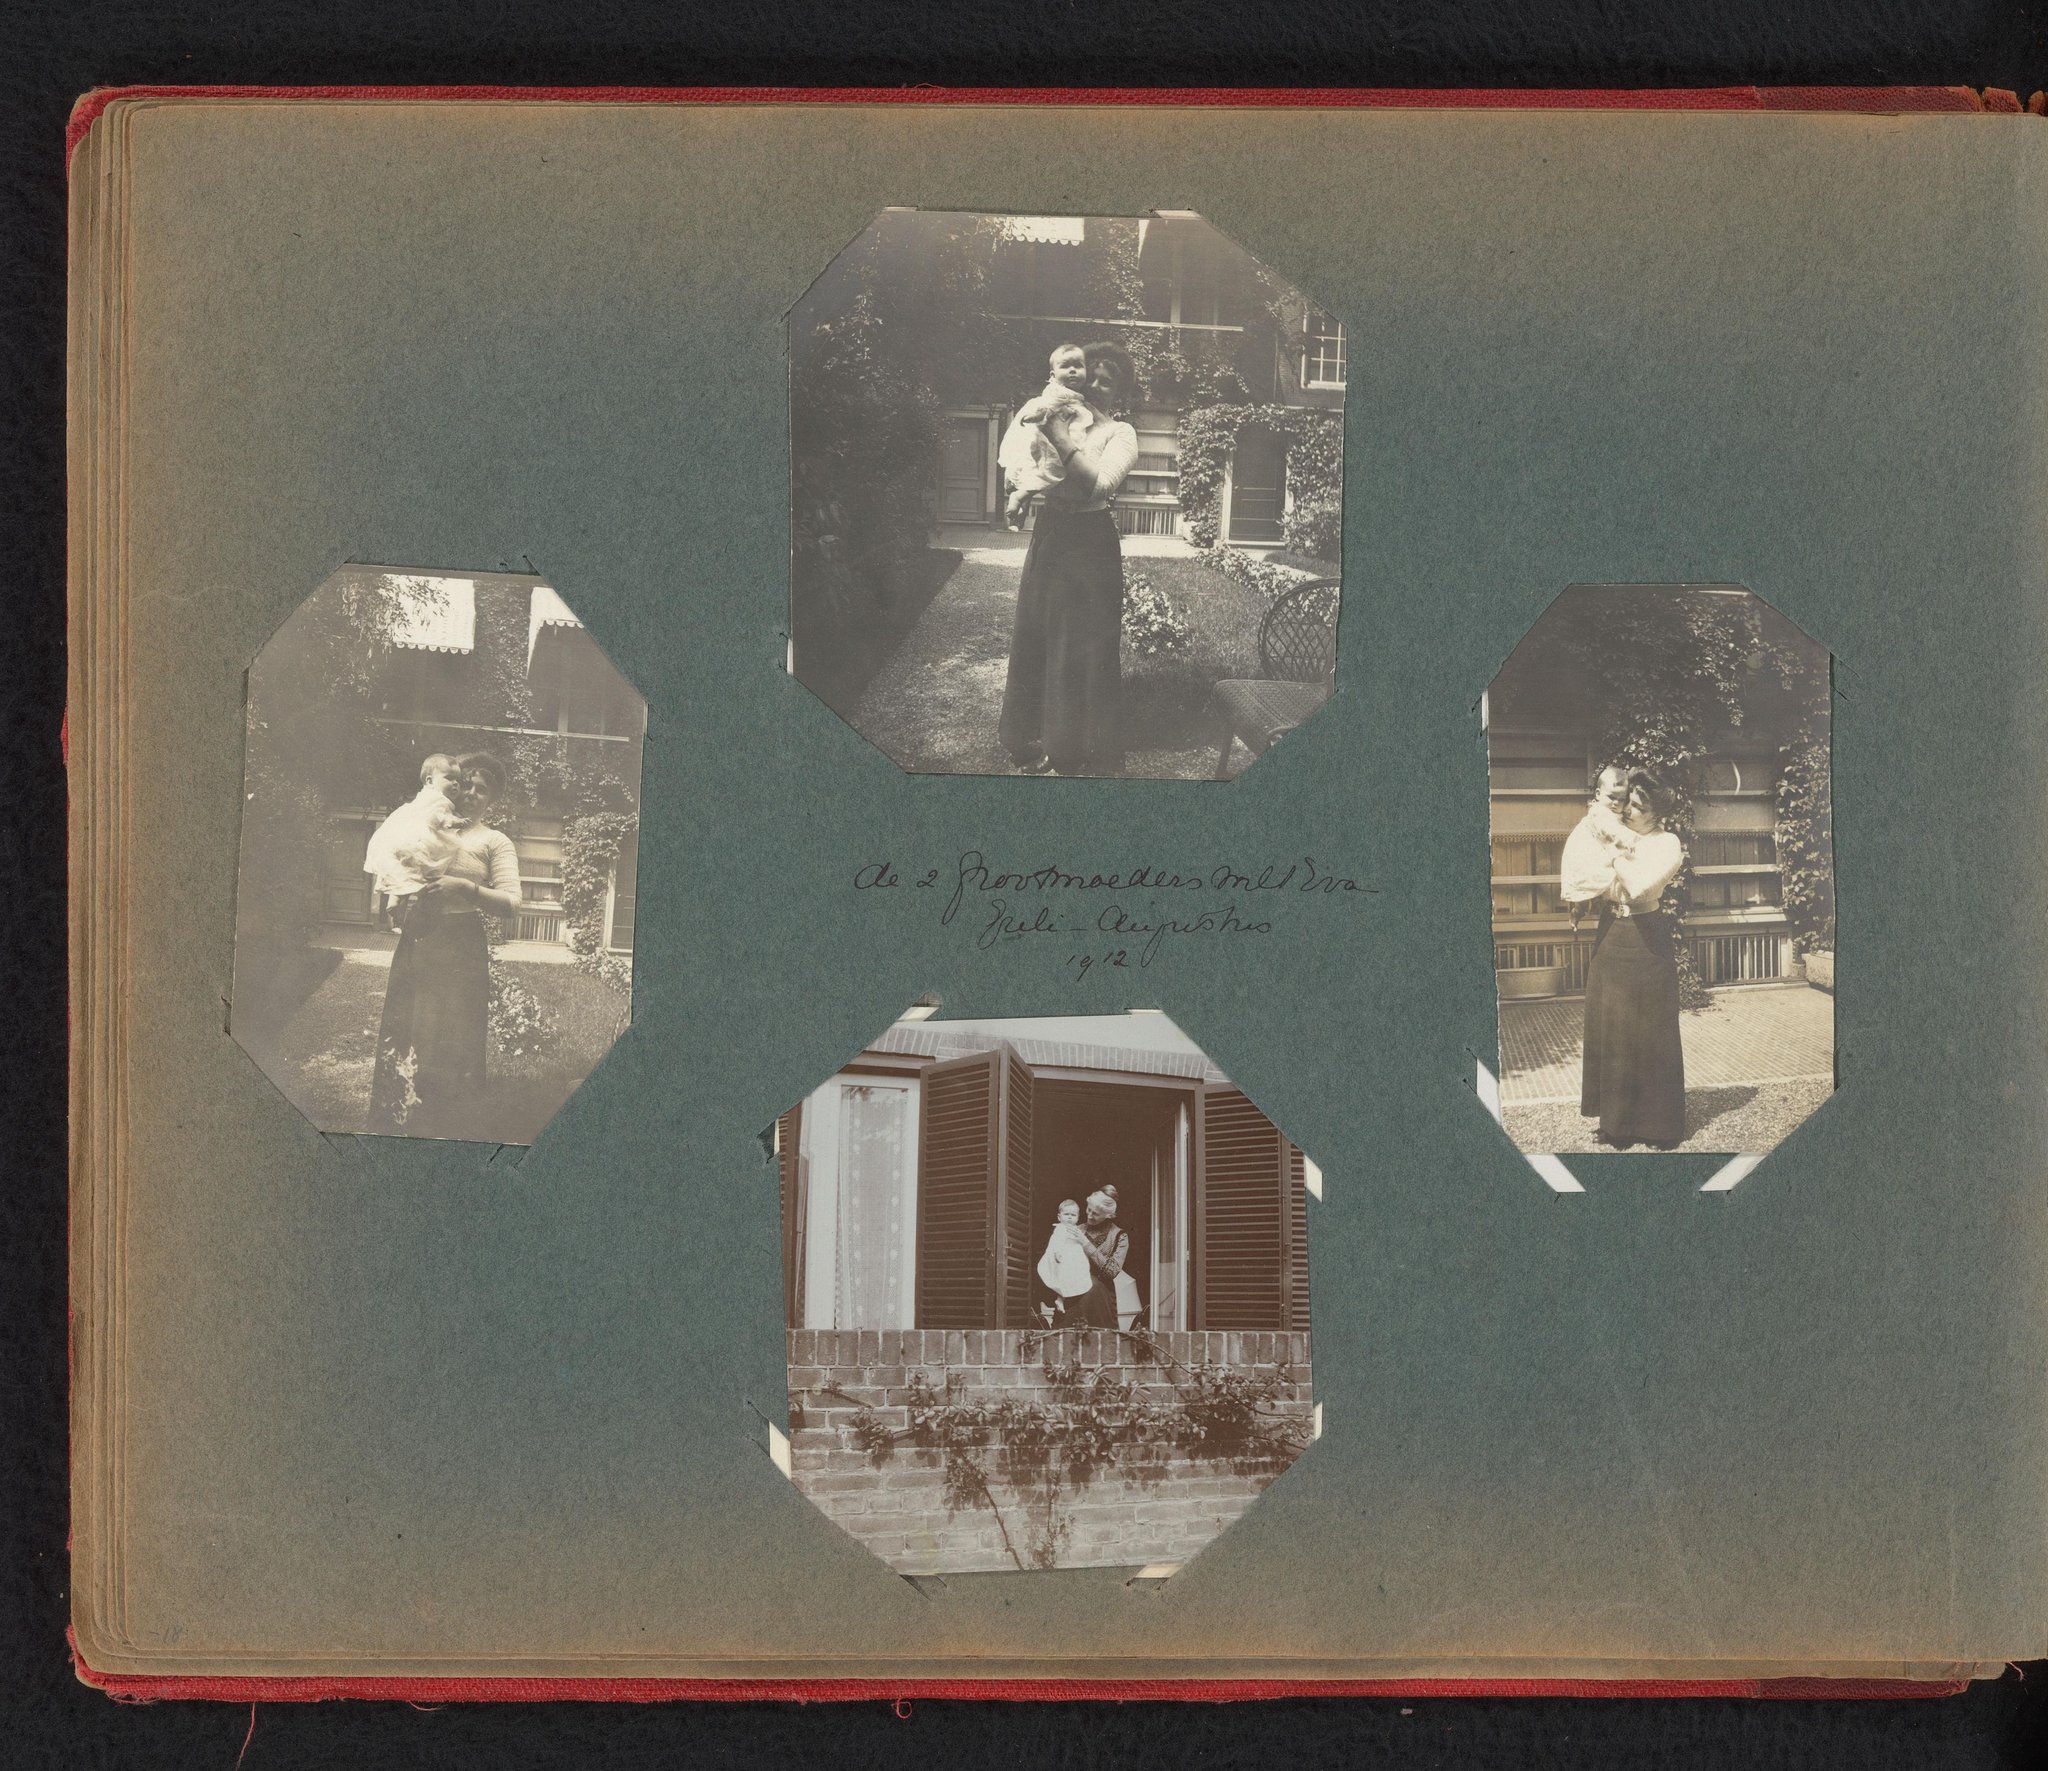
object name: photograph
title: De 2 grootmoeders met Eva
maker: charlotte alida boelen-matthes (lot)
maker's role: amateurfotograaf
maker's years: 1889-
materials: paper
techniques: gelatin silver print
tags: amsterdam, eva charlotte pennink-boelen, child(ren) with other members of the family, garden, infant, baby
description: Deze foto's zijn onderdeel van een album.